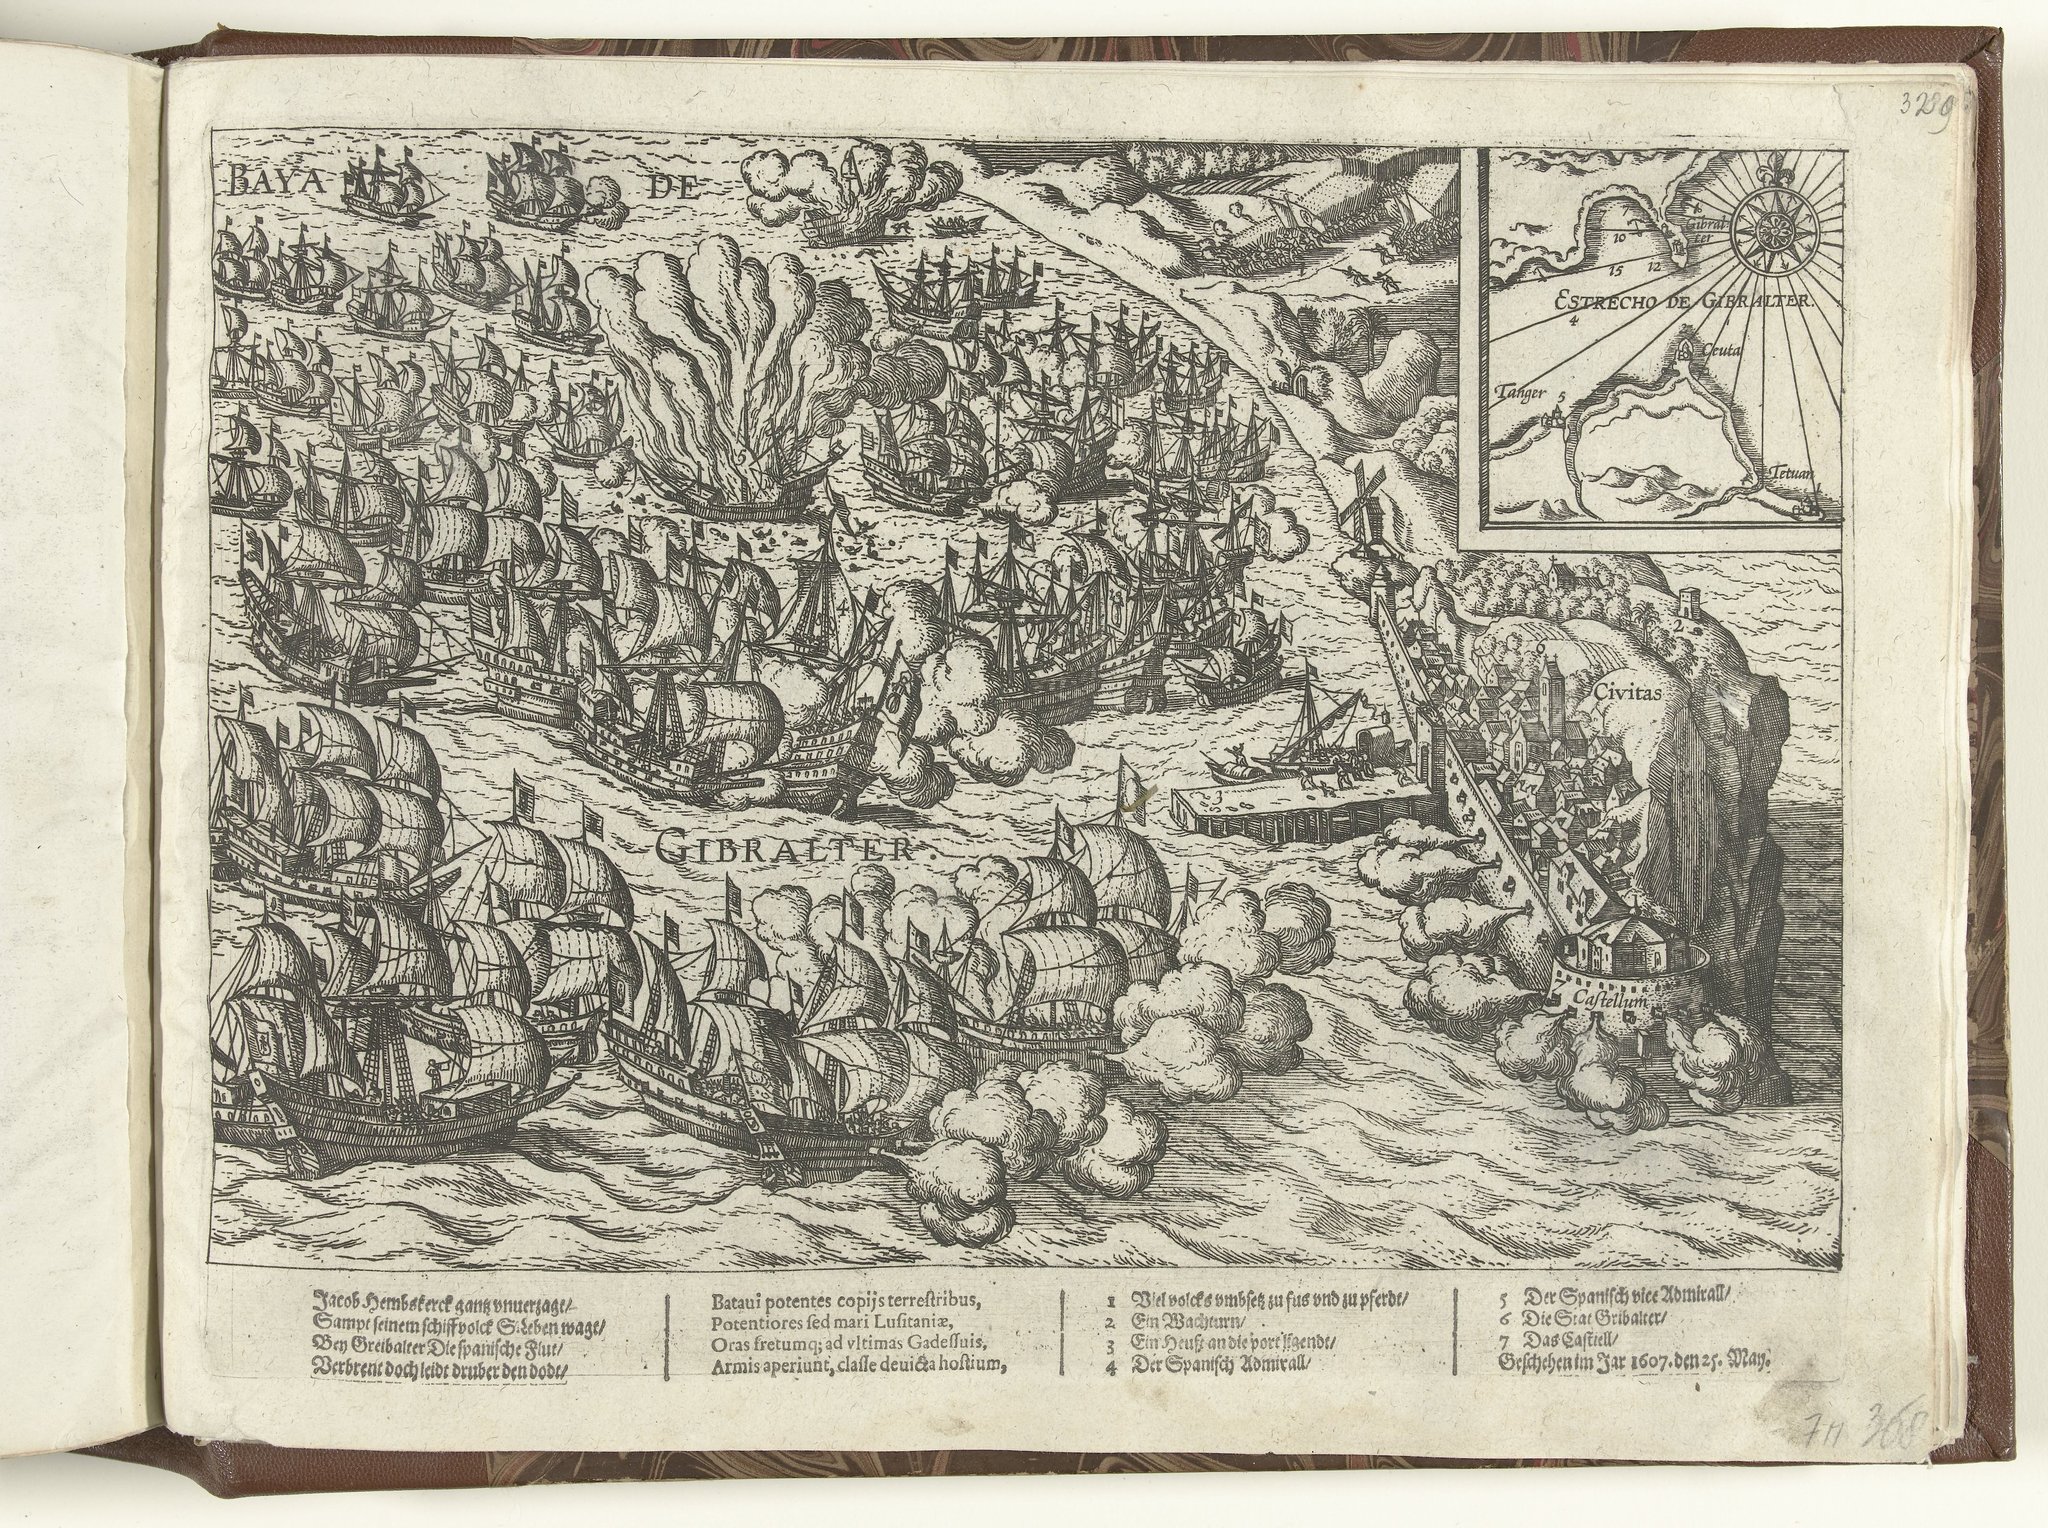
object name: album leaf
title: Zeeslag bij Gibraltar, 1607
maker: frans hogenberg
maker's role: print maker, publisher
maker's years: 1538-1590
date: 1607-1609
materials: paper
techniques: etching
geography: cologne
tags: amsterdam, jacob van heemskerck, battle (+ naval force)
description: Zeeslag bij Gibraltar, 25 april (niet 25 mei zoals op de prent vermeld) 1607 tussen de Nederlandse en de Spaanse vloot. Boven inzet met kaart van de Straat van Gibraltar. Met onderschrift van 4 regels in het Duits en 4 regels in het Latijn en legenda van de nummers 1-7. Ongenummerd.